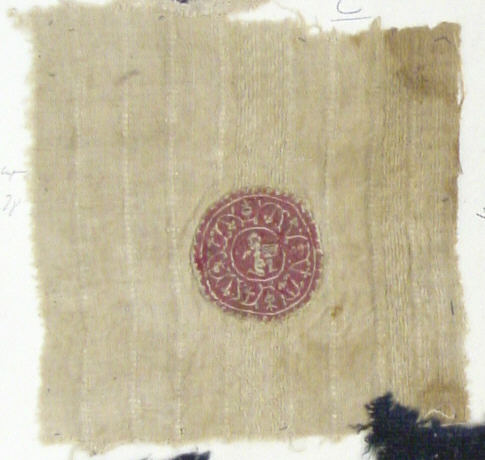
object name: textile fragment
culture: coptic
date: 401-600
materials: linen, wool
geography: egypt